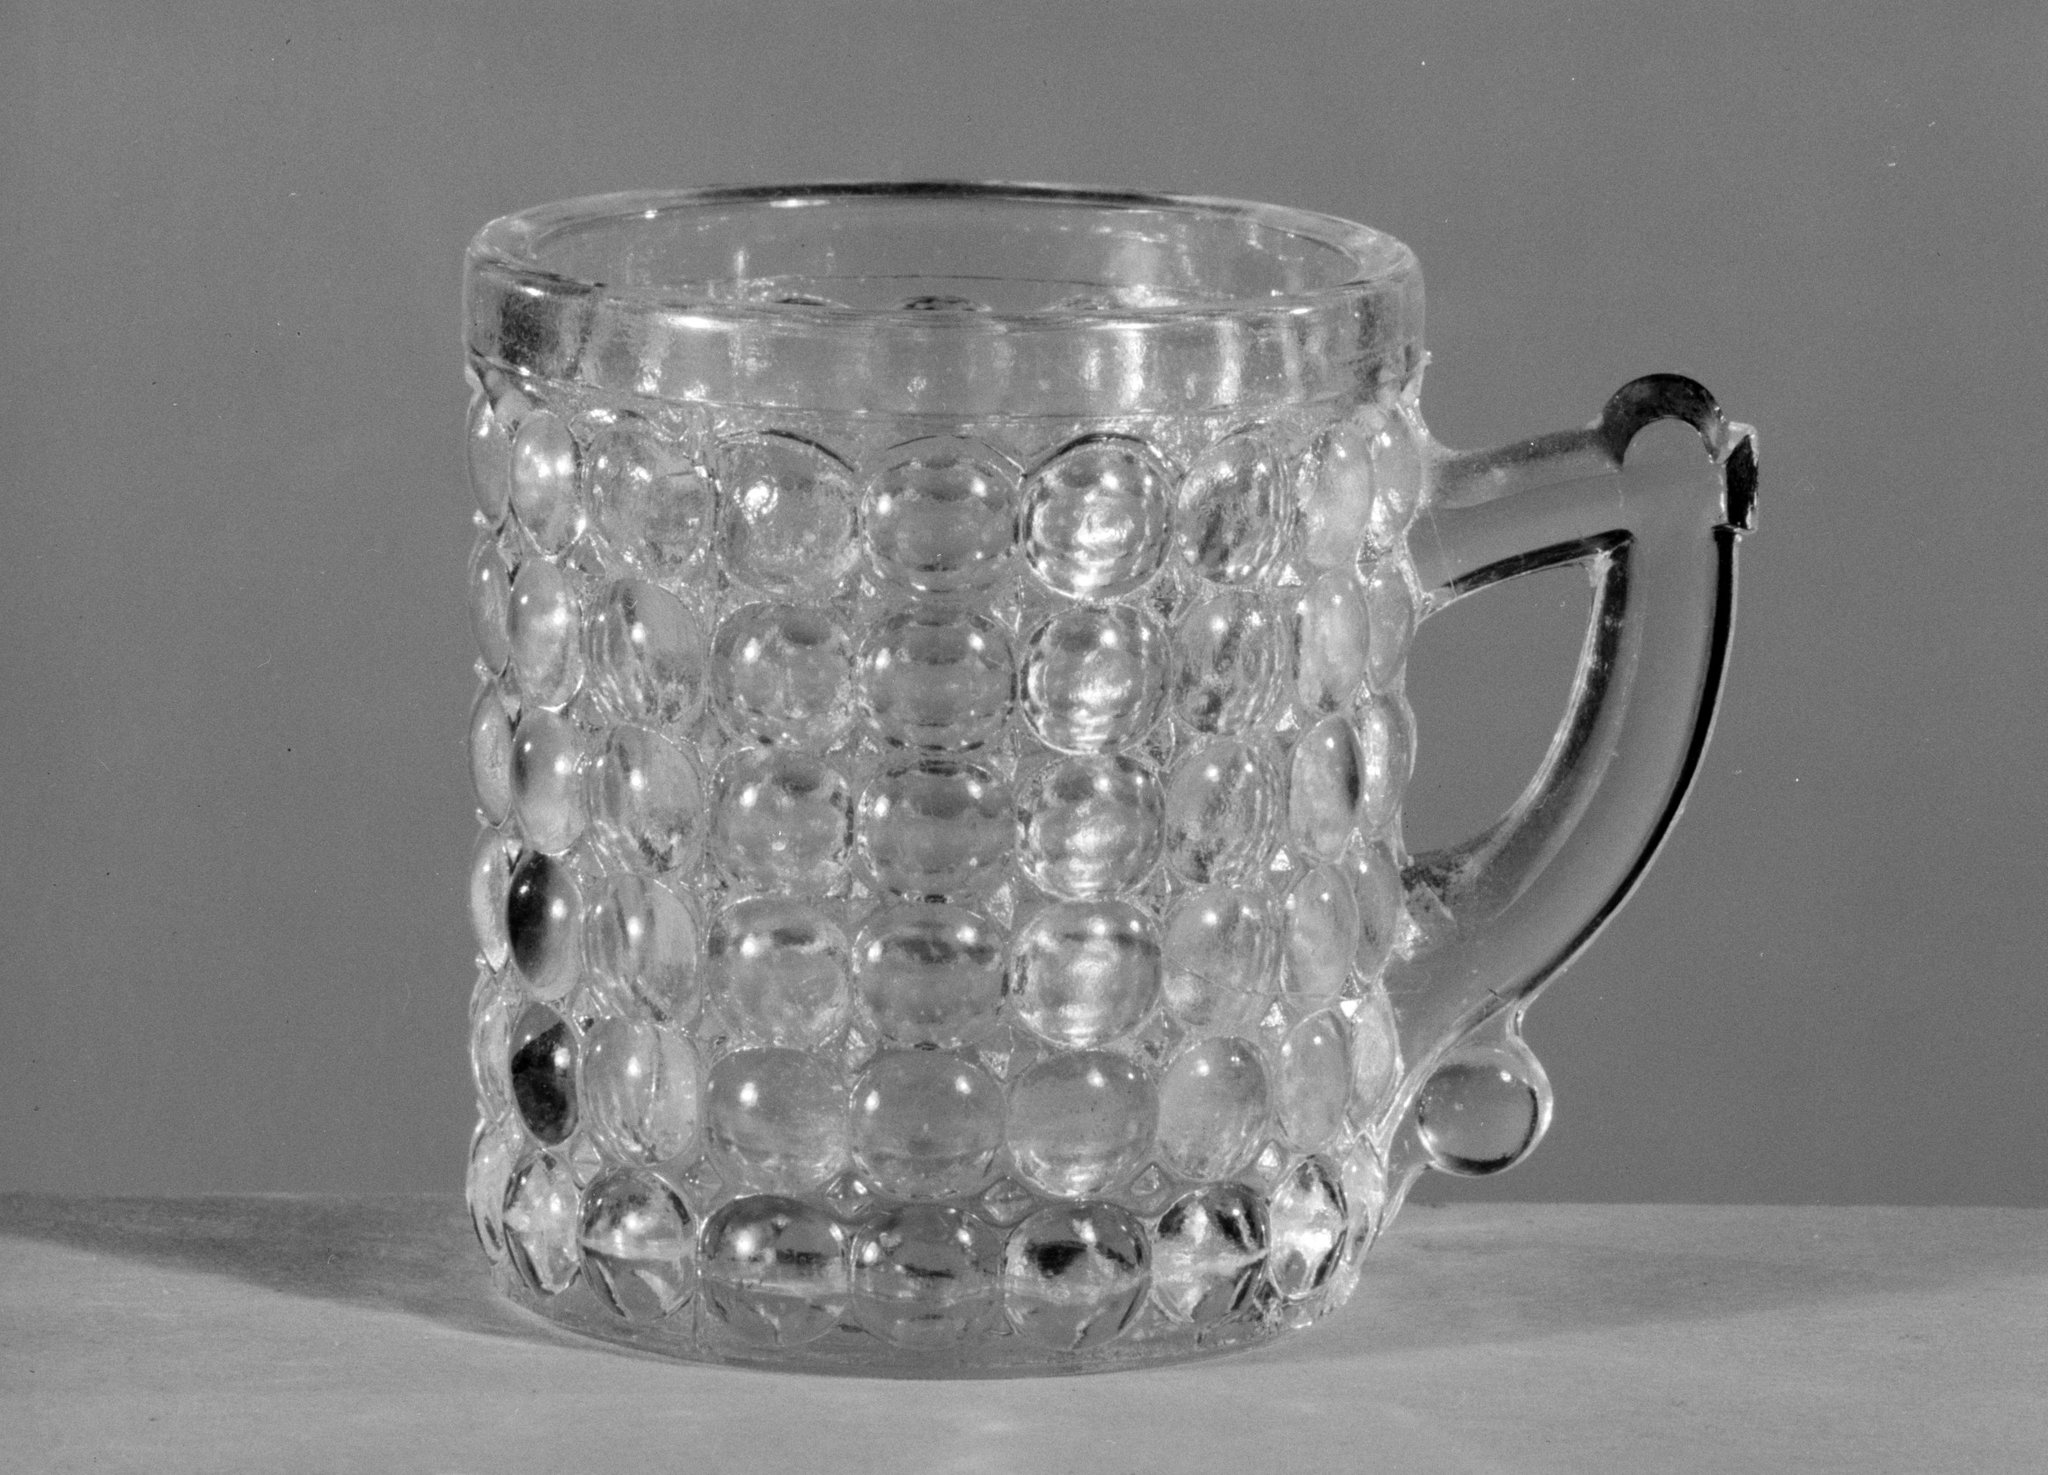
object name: mug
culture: american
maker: adams and company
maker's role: maker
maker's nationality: american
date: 1870-1890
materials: glass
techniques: pressed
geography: united states